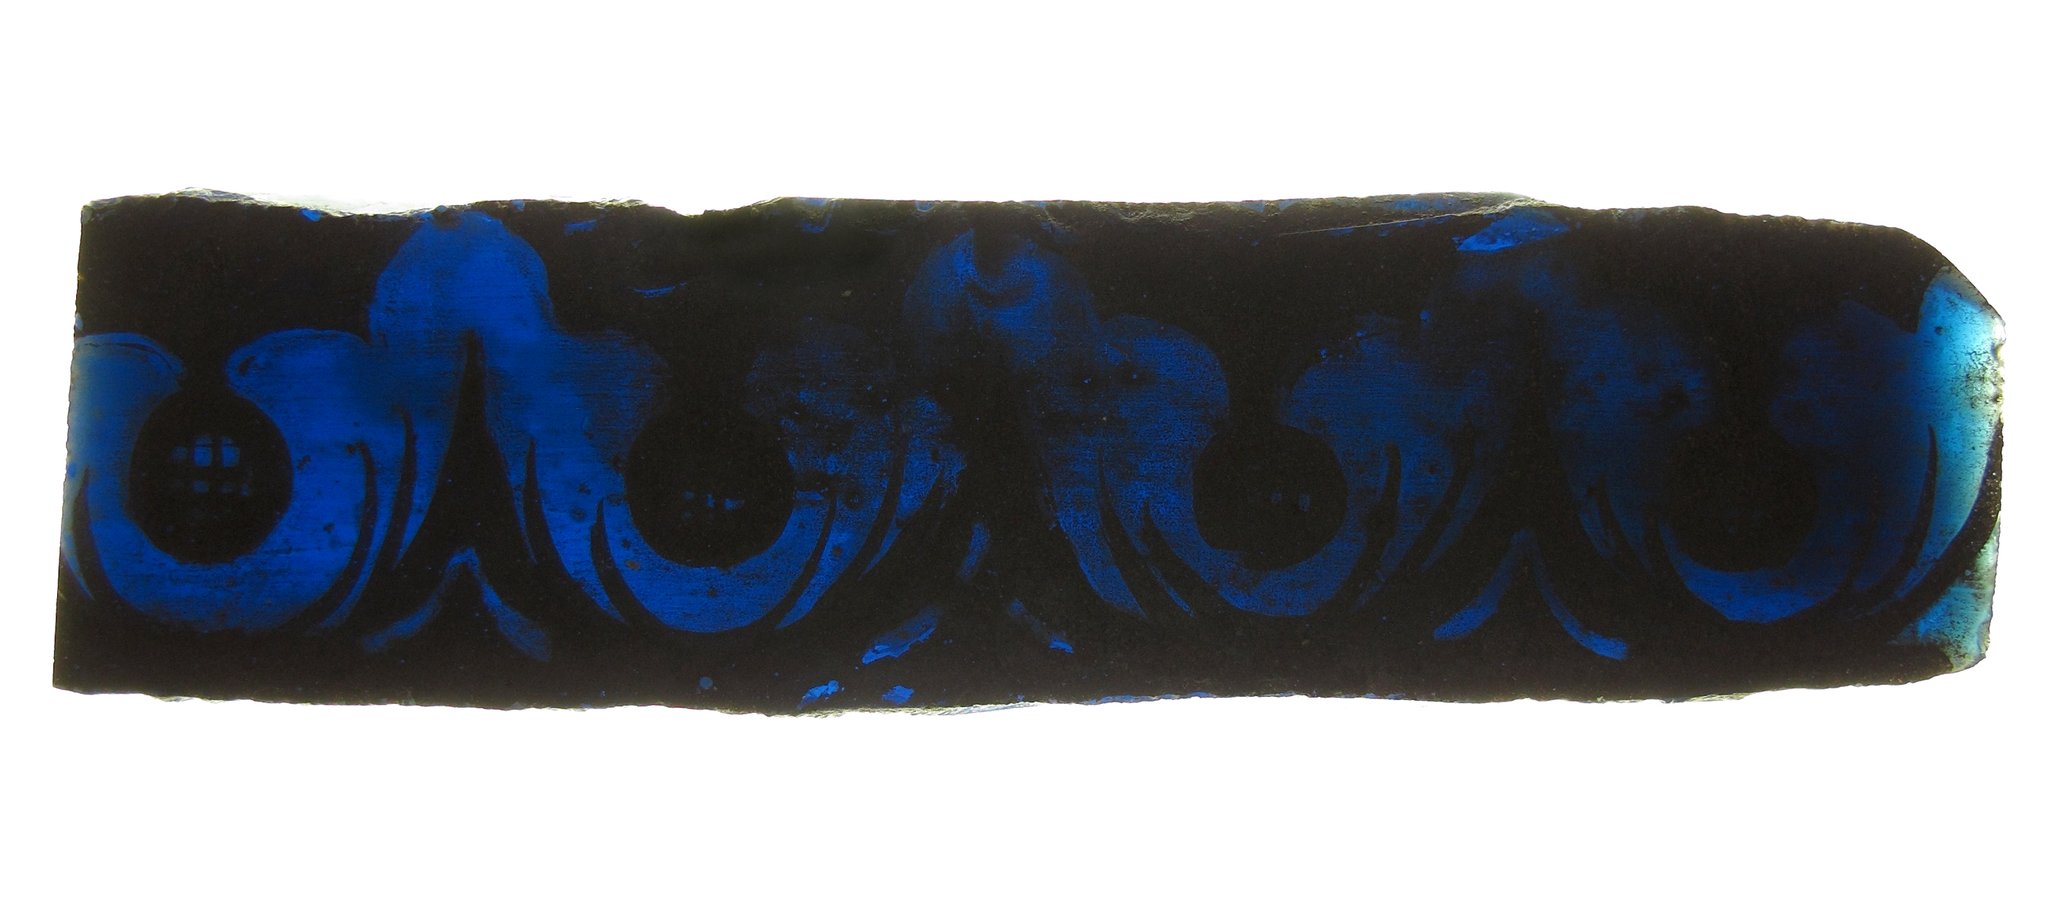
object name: fragment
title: Glass Fragment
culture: european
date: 1201-1300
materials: glass, metal